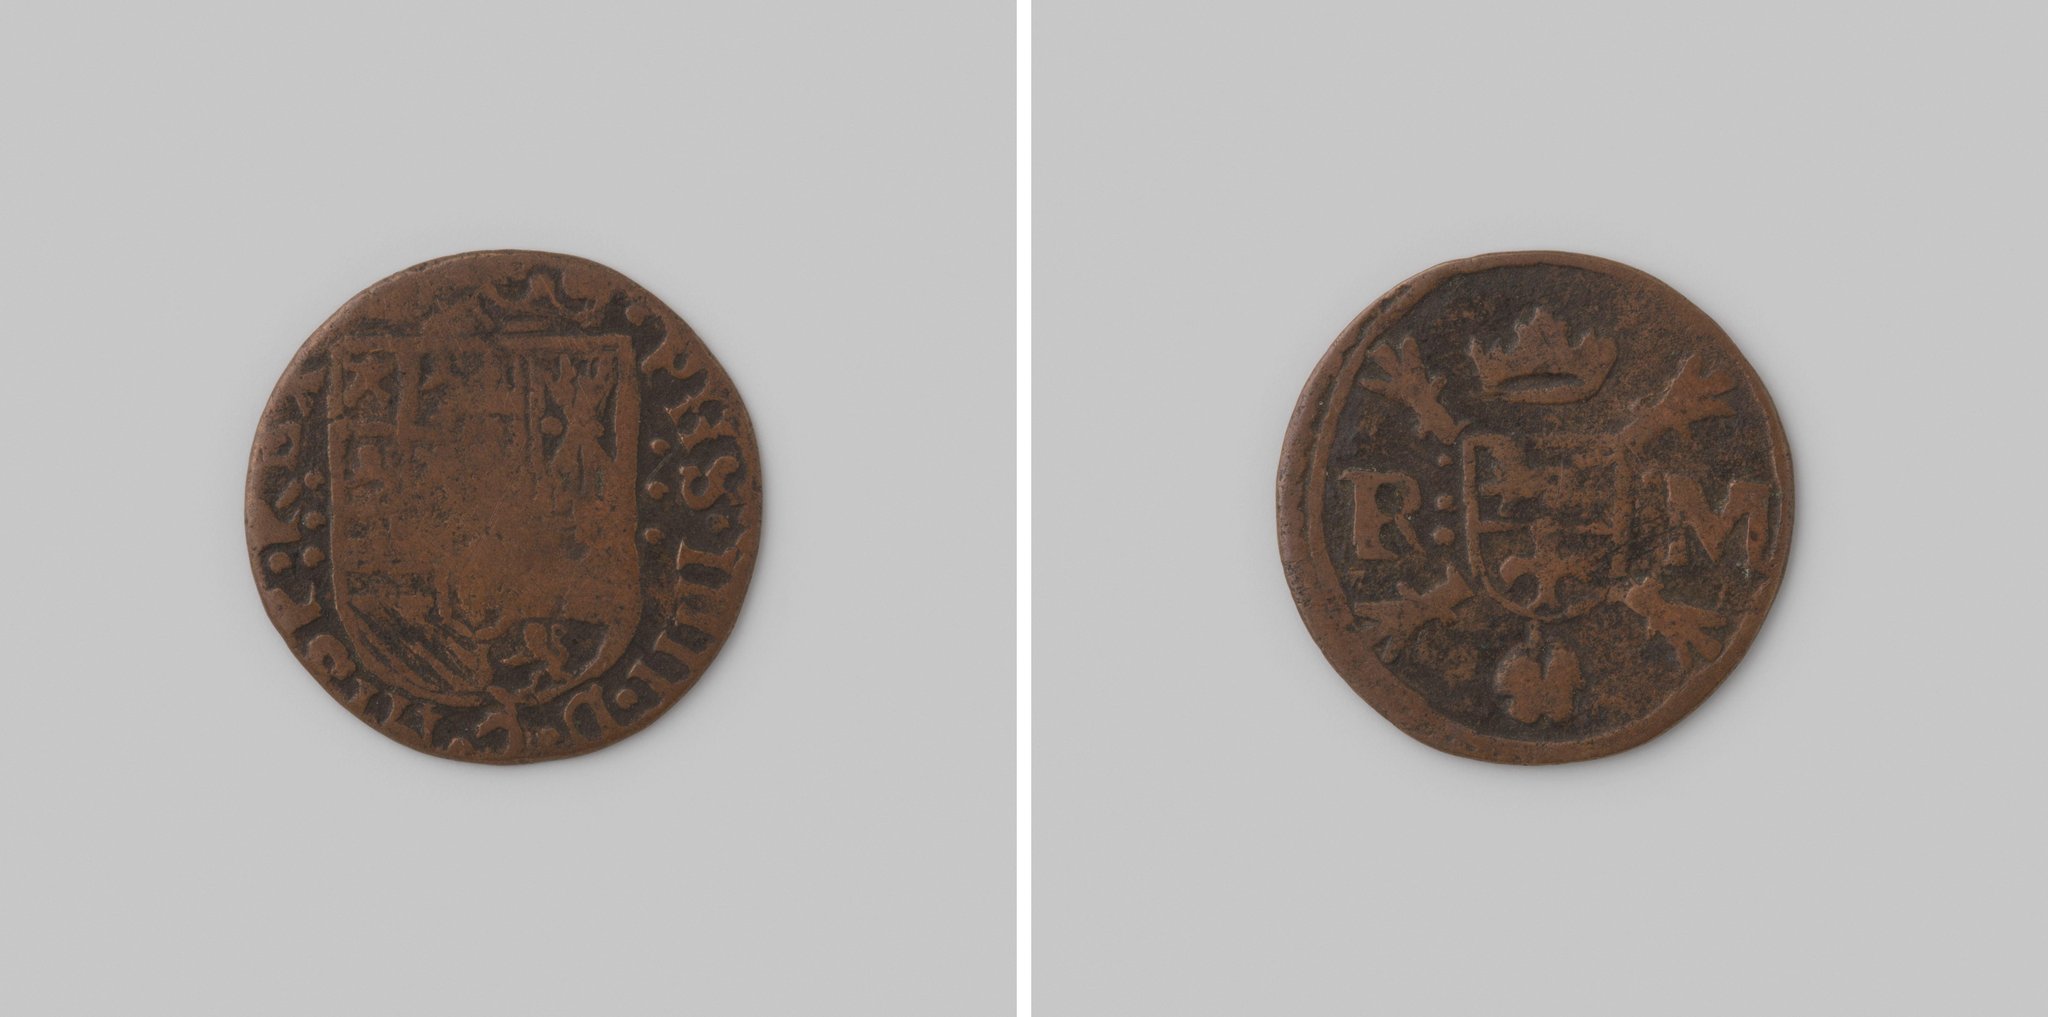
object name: coin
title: Roermondse duit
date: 1659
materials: copper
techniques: striking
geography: roermond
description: Voorzijde: gekroond wapenschild van koning Philips IV met in omschrift: PHS IIIII. Keerzijde: op stokkenkruis gekroond wapenschild van Roermond, in de zijkantons R en M.